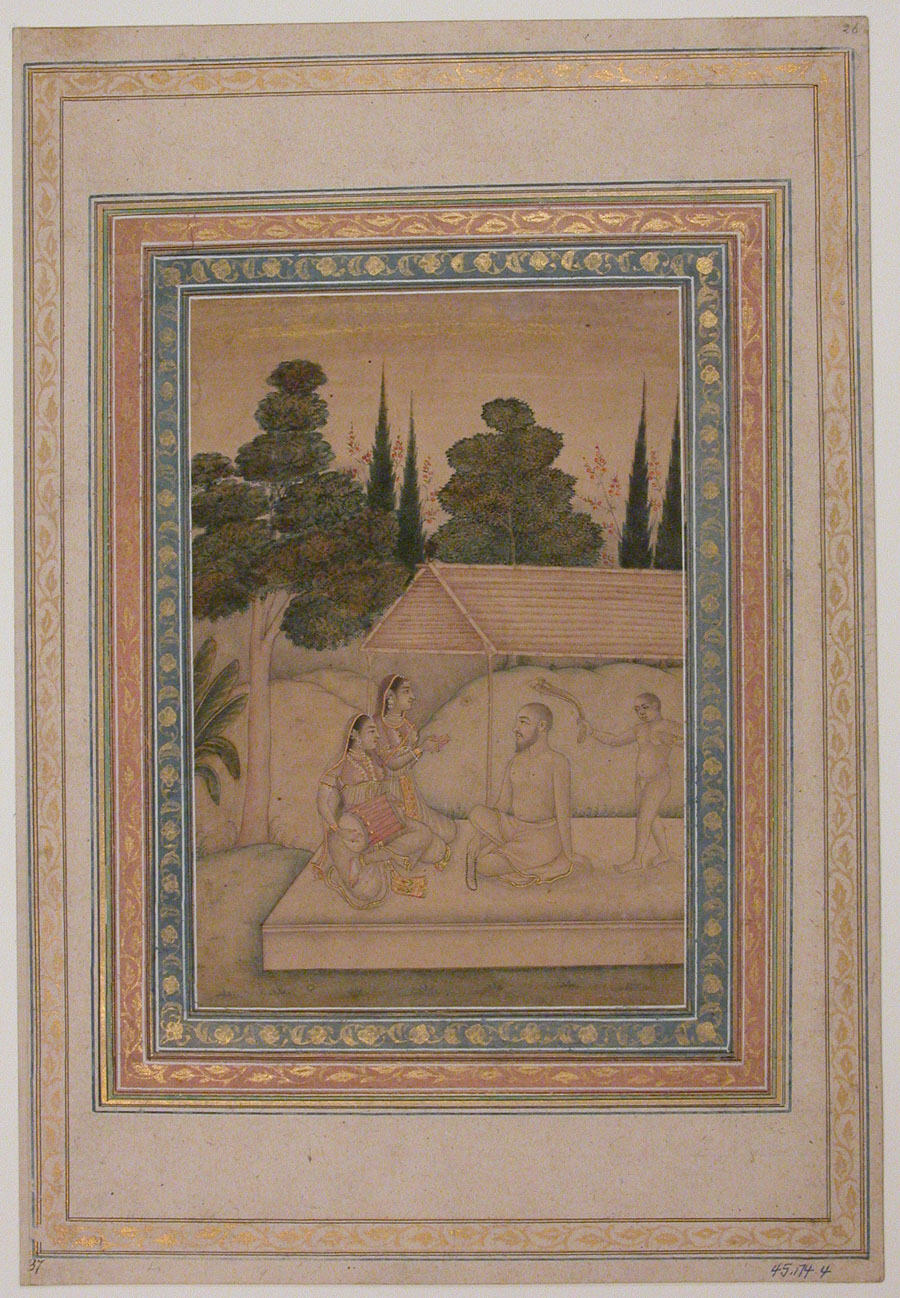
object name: album leaf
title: Musicians Entertaining a Holy Man (Sadhu or Fakir)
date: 1701-1800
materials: gold, ink, paper, watercolor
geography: india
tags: musical instruments,men,women,musicians